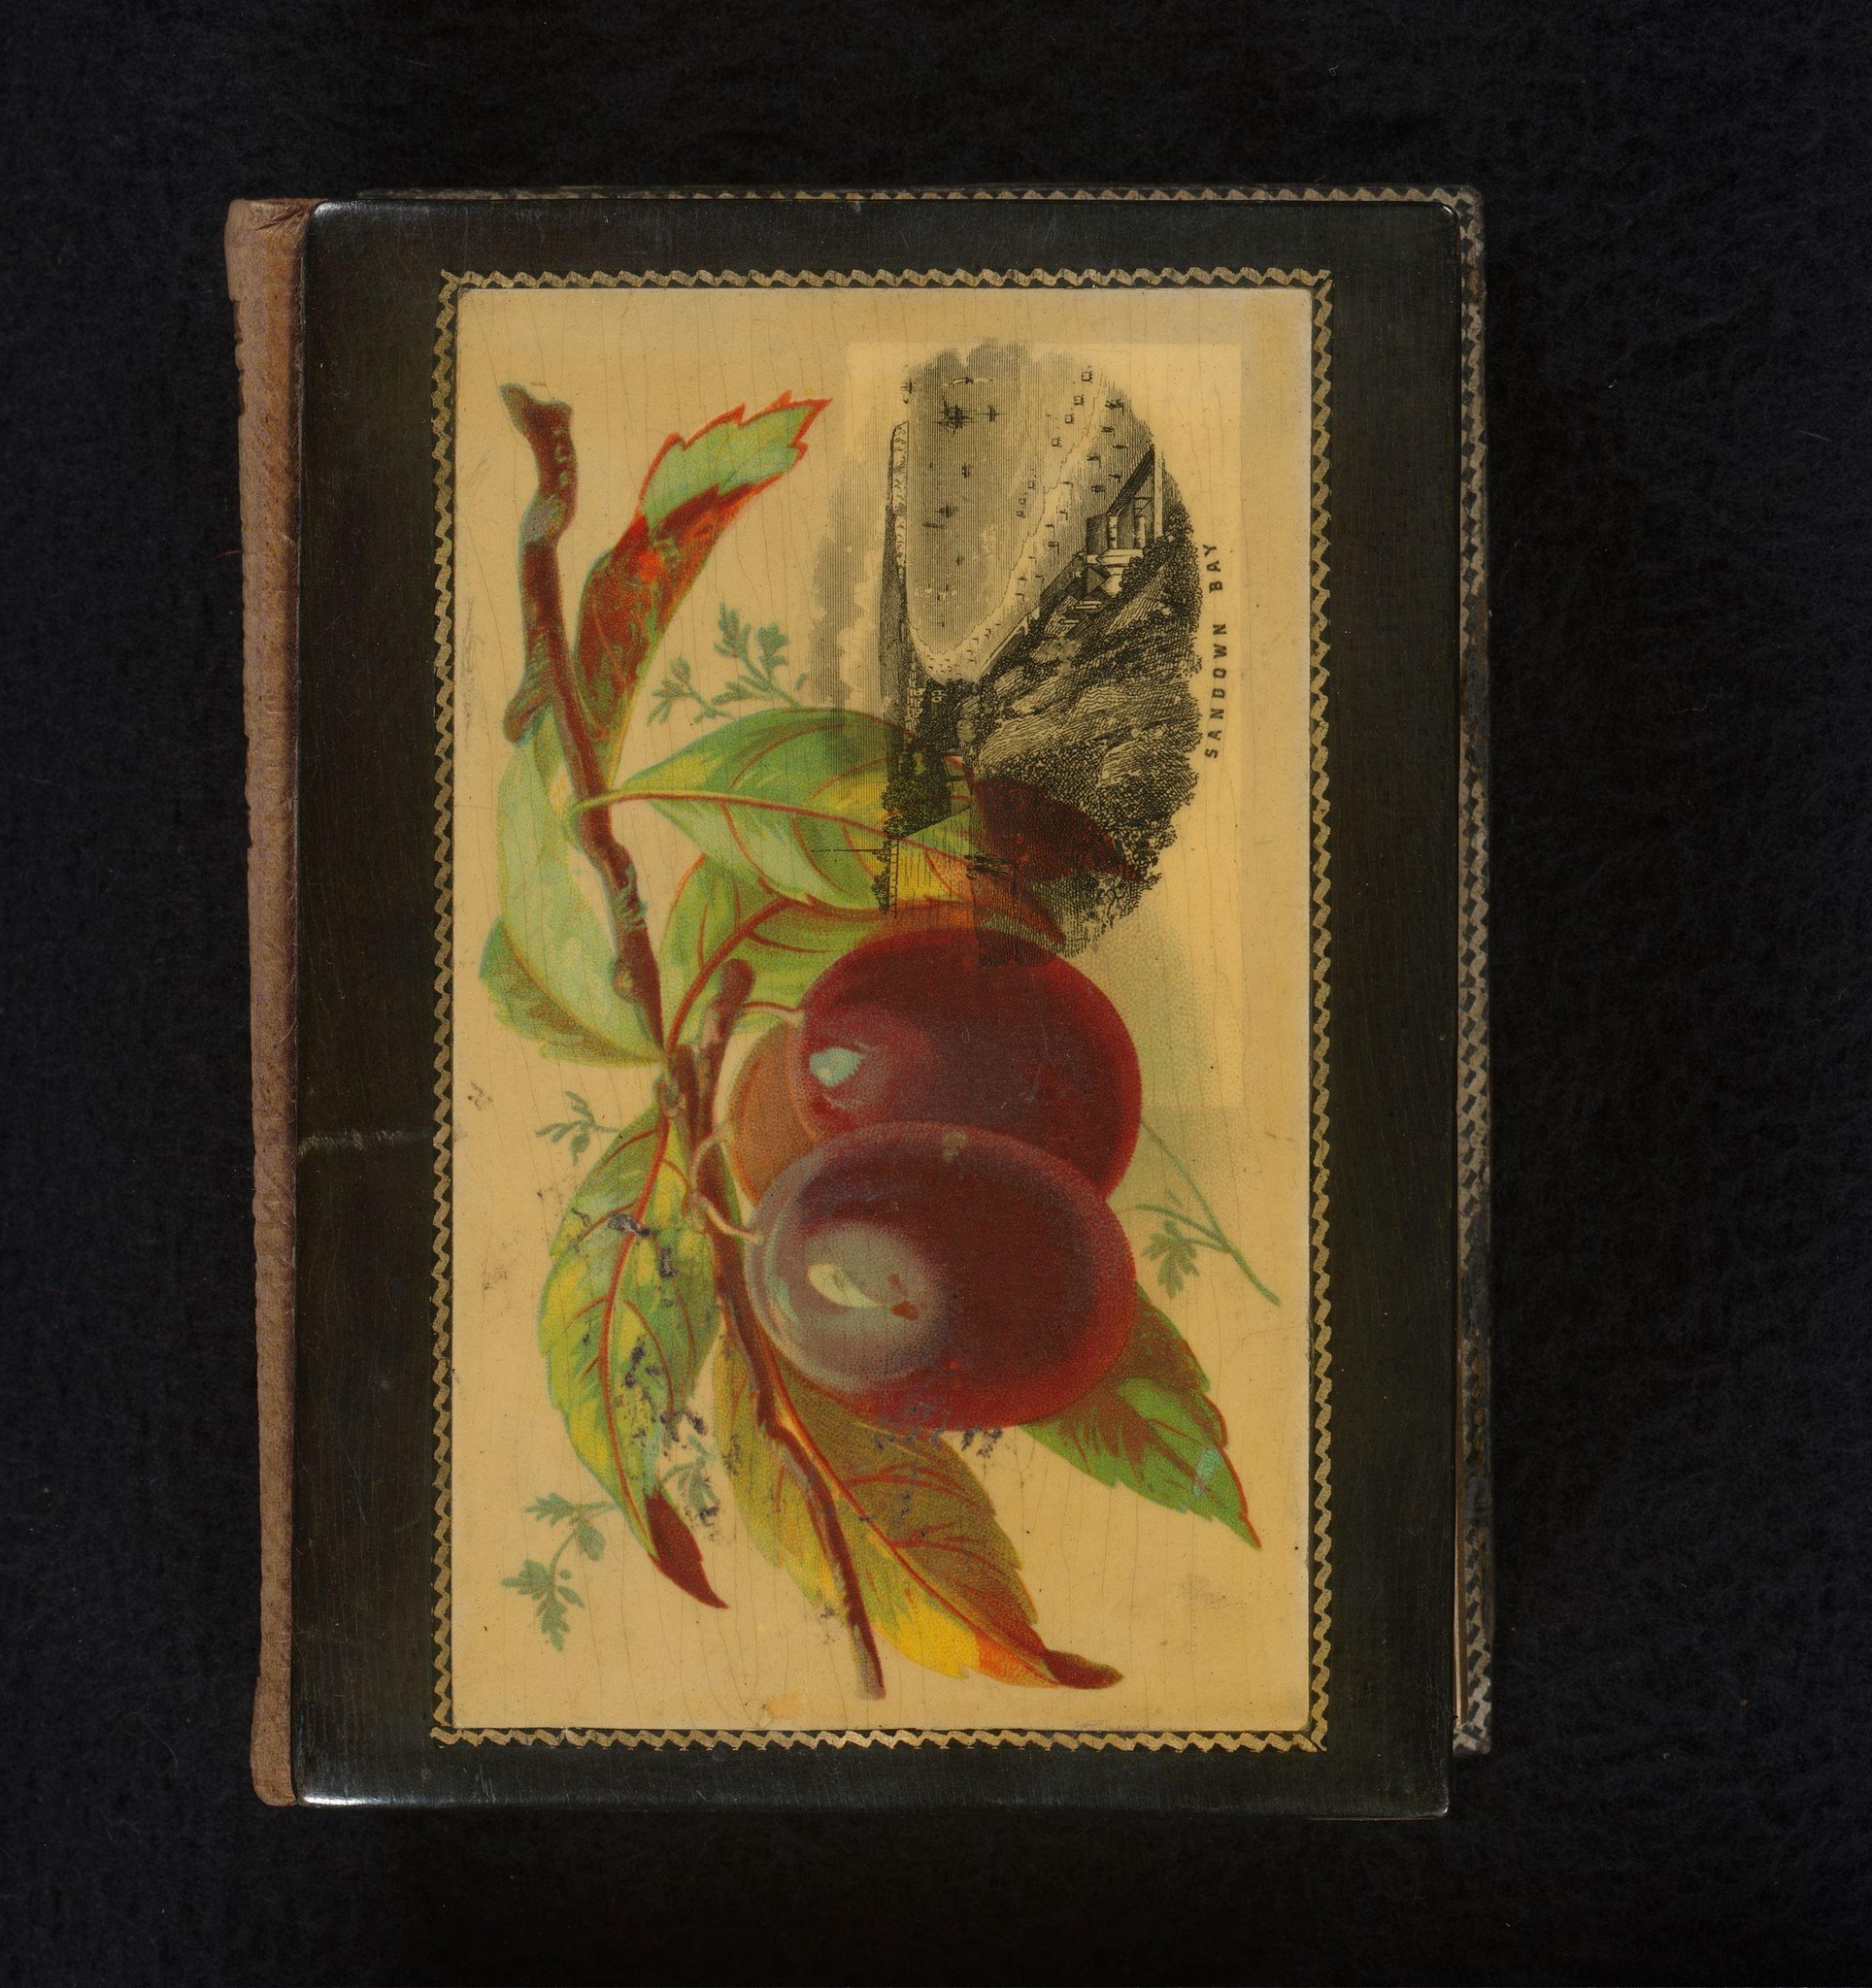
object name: slip in album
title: Fotoalbum met 14 portretten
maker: Anonymous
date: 1860-1920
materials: cardboard, leather, photographic support, wood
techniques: albumen print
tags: sitting figure, adult woman, adult man, child, historical persons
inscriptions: annotation: ‘To dear Jane [...]/ from/ Bertien, Ella, Alice & Mabel/ Augst 27th/ 78’, inscription: ‘Dienst Verspreide Rijkskollekties/ (...)’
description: Fotoalbum met 14 pagina's met in totaal 14 foto's, allen cartes-de-visite. Bijna allemaal portretten.